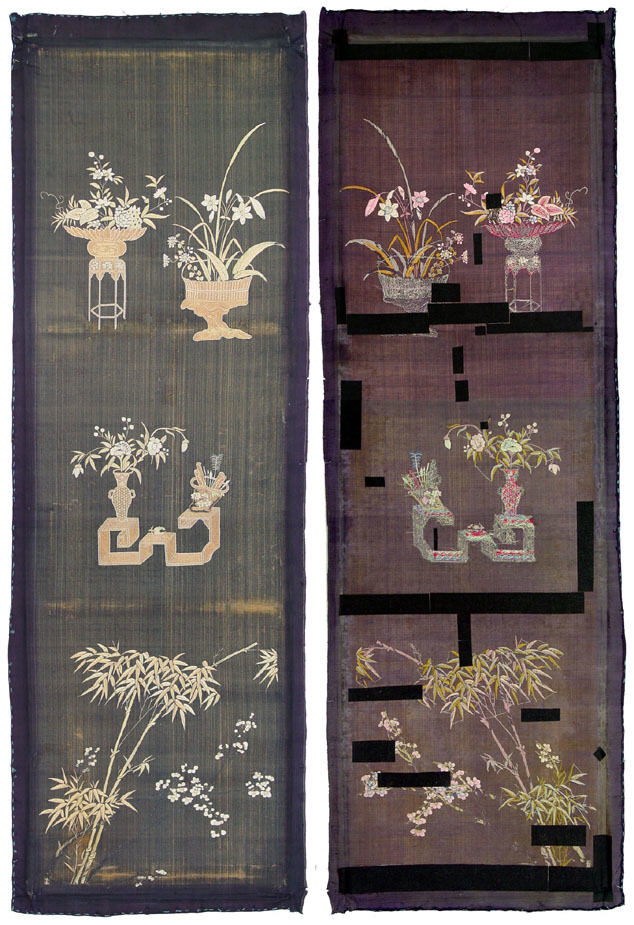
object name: panel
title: Embroidered Panel (from set of four)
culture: chinese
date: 1801-1900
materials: metal thread, silk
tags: flowers,bamboo